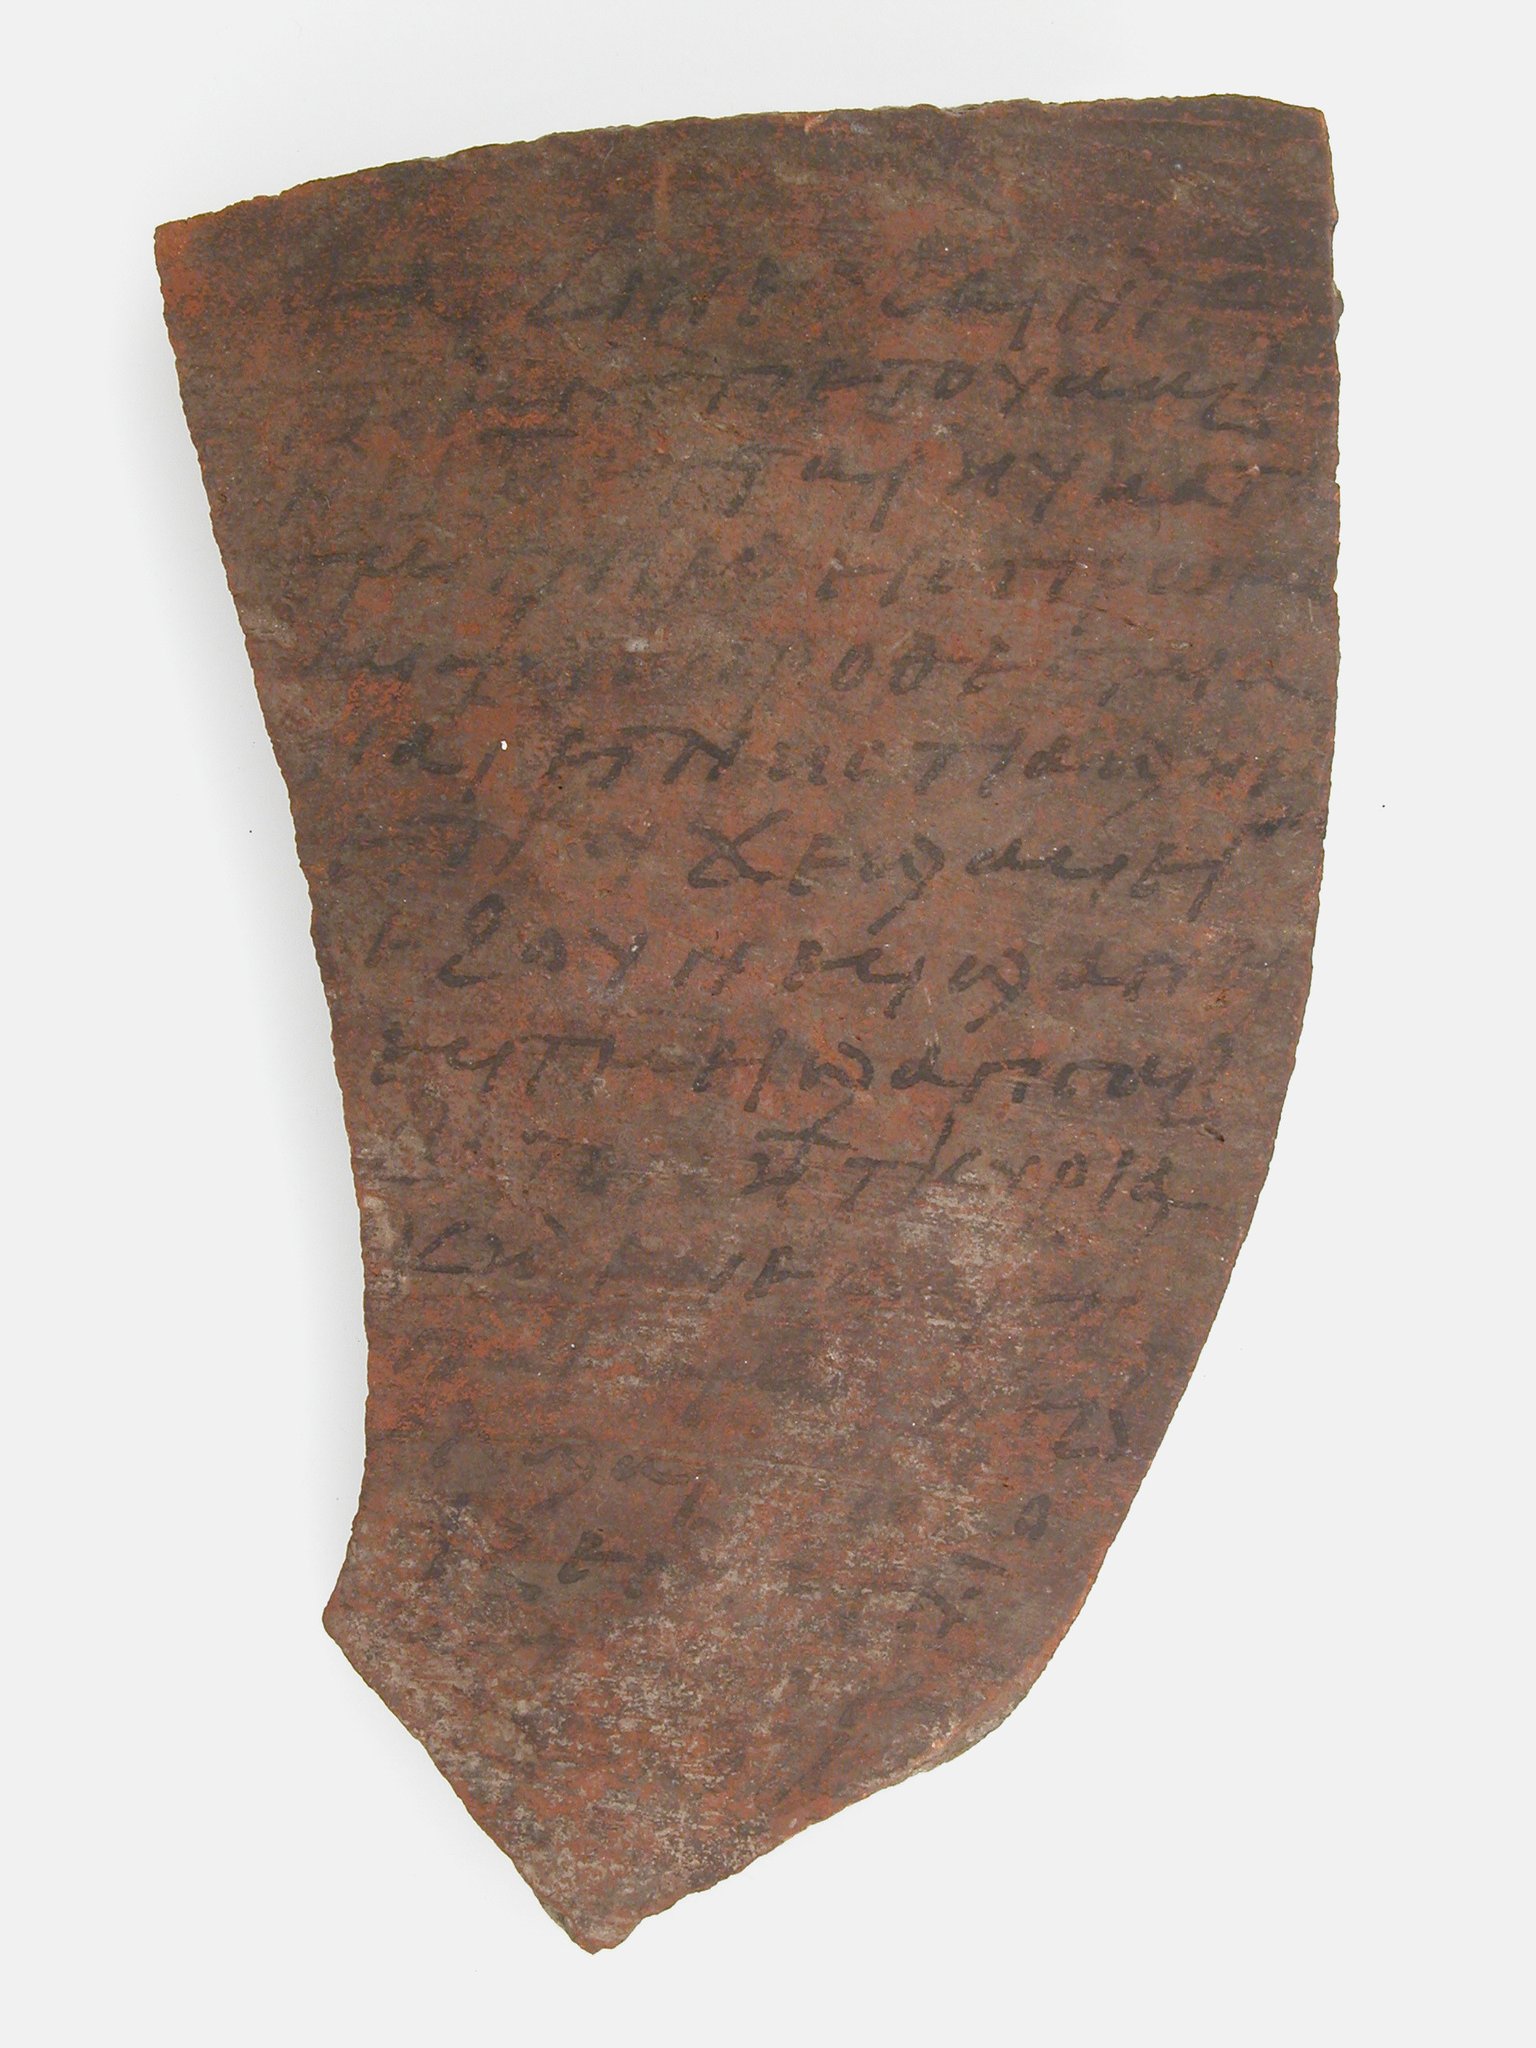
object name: ostrakon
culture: coptic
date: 601-700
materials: ink, pottery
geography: egypt